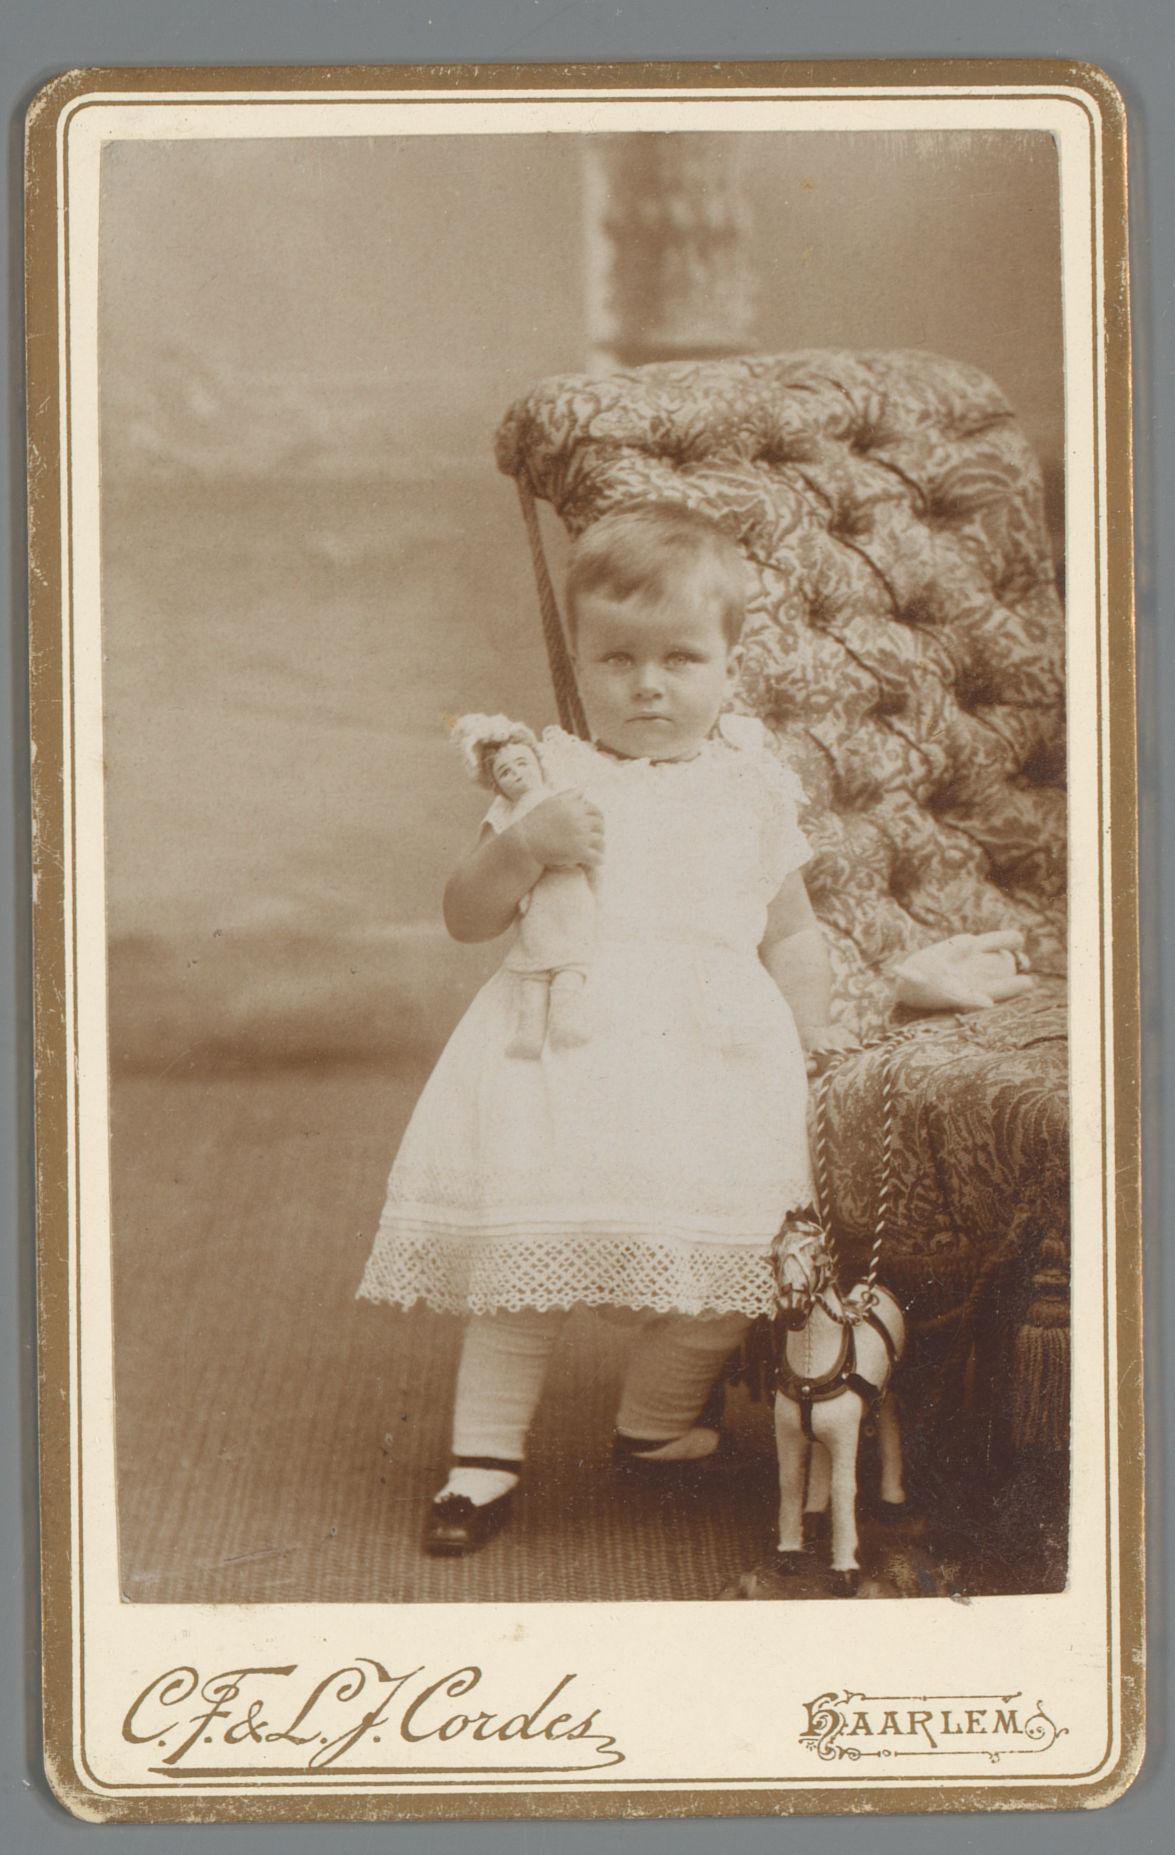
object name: carte de visite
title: Portret van Johanna Geertruida Jonker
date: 1897-1898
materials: cardboard, photographic support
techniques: collodion silver print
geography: haarlem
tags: historical persons, haarlem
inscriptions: workshop stamp: ‘C.F. & L.J. Cordes/ Haarlem, Groote Houtstraat 84/ 's Bosch a/d. Parade’, annotation: ‘2 jaar/ Hansje’